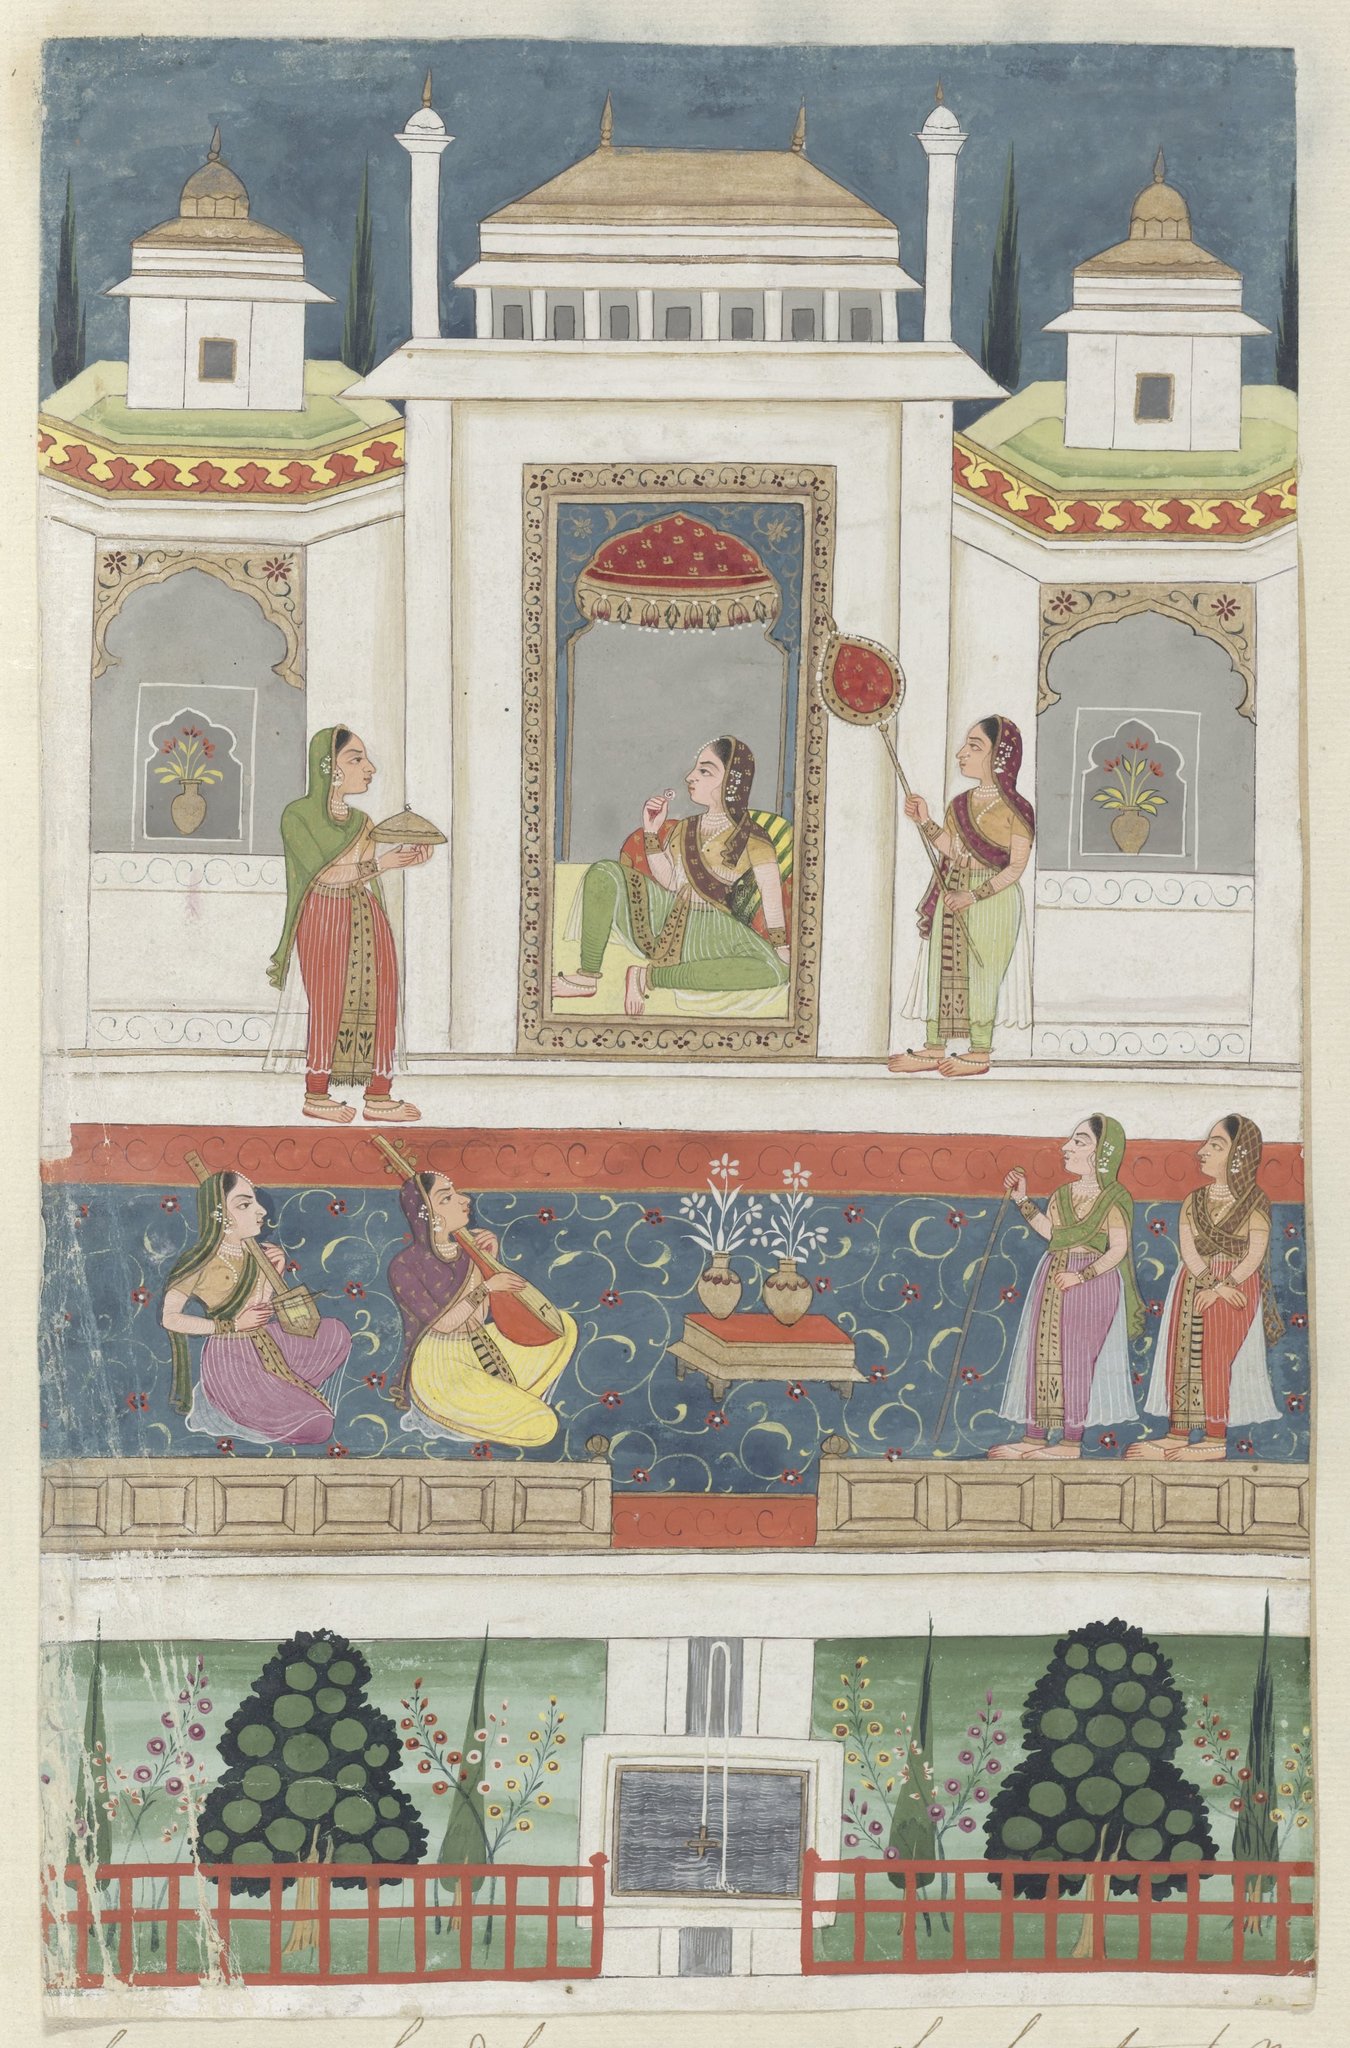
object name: drawing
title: De koninginne chandohaan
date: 1675-1725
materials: paper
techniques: drawing, writing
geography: deccan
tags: adrianus canter visscher, queen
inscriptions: caption: ‘De koninginne chandohaan, vrouwe van cha jehaan tiende mogol / van Indostan’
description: Tekening uit het manuscript van de VOC dienaar Adrianus Canter Visscher met achterin achtentwintig Indiase miniaturen en twee kaarten van plaatsen aan de Coromandelkust. De tekst bestaat uit twee delen: een geschiedenis van het Mogolrijk en de VOC-vestigingen aan de Coromandelkust; daarna volgt een advies aan de Heren XVII over de economische situatie van de VOC in de Coromandel.